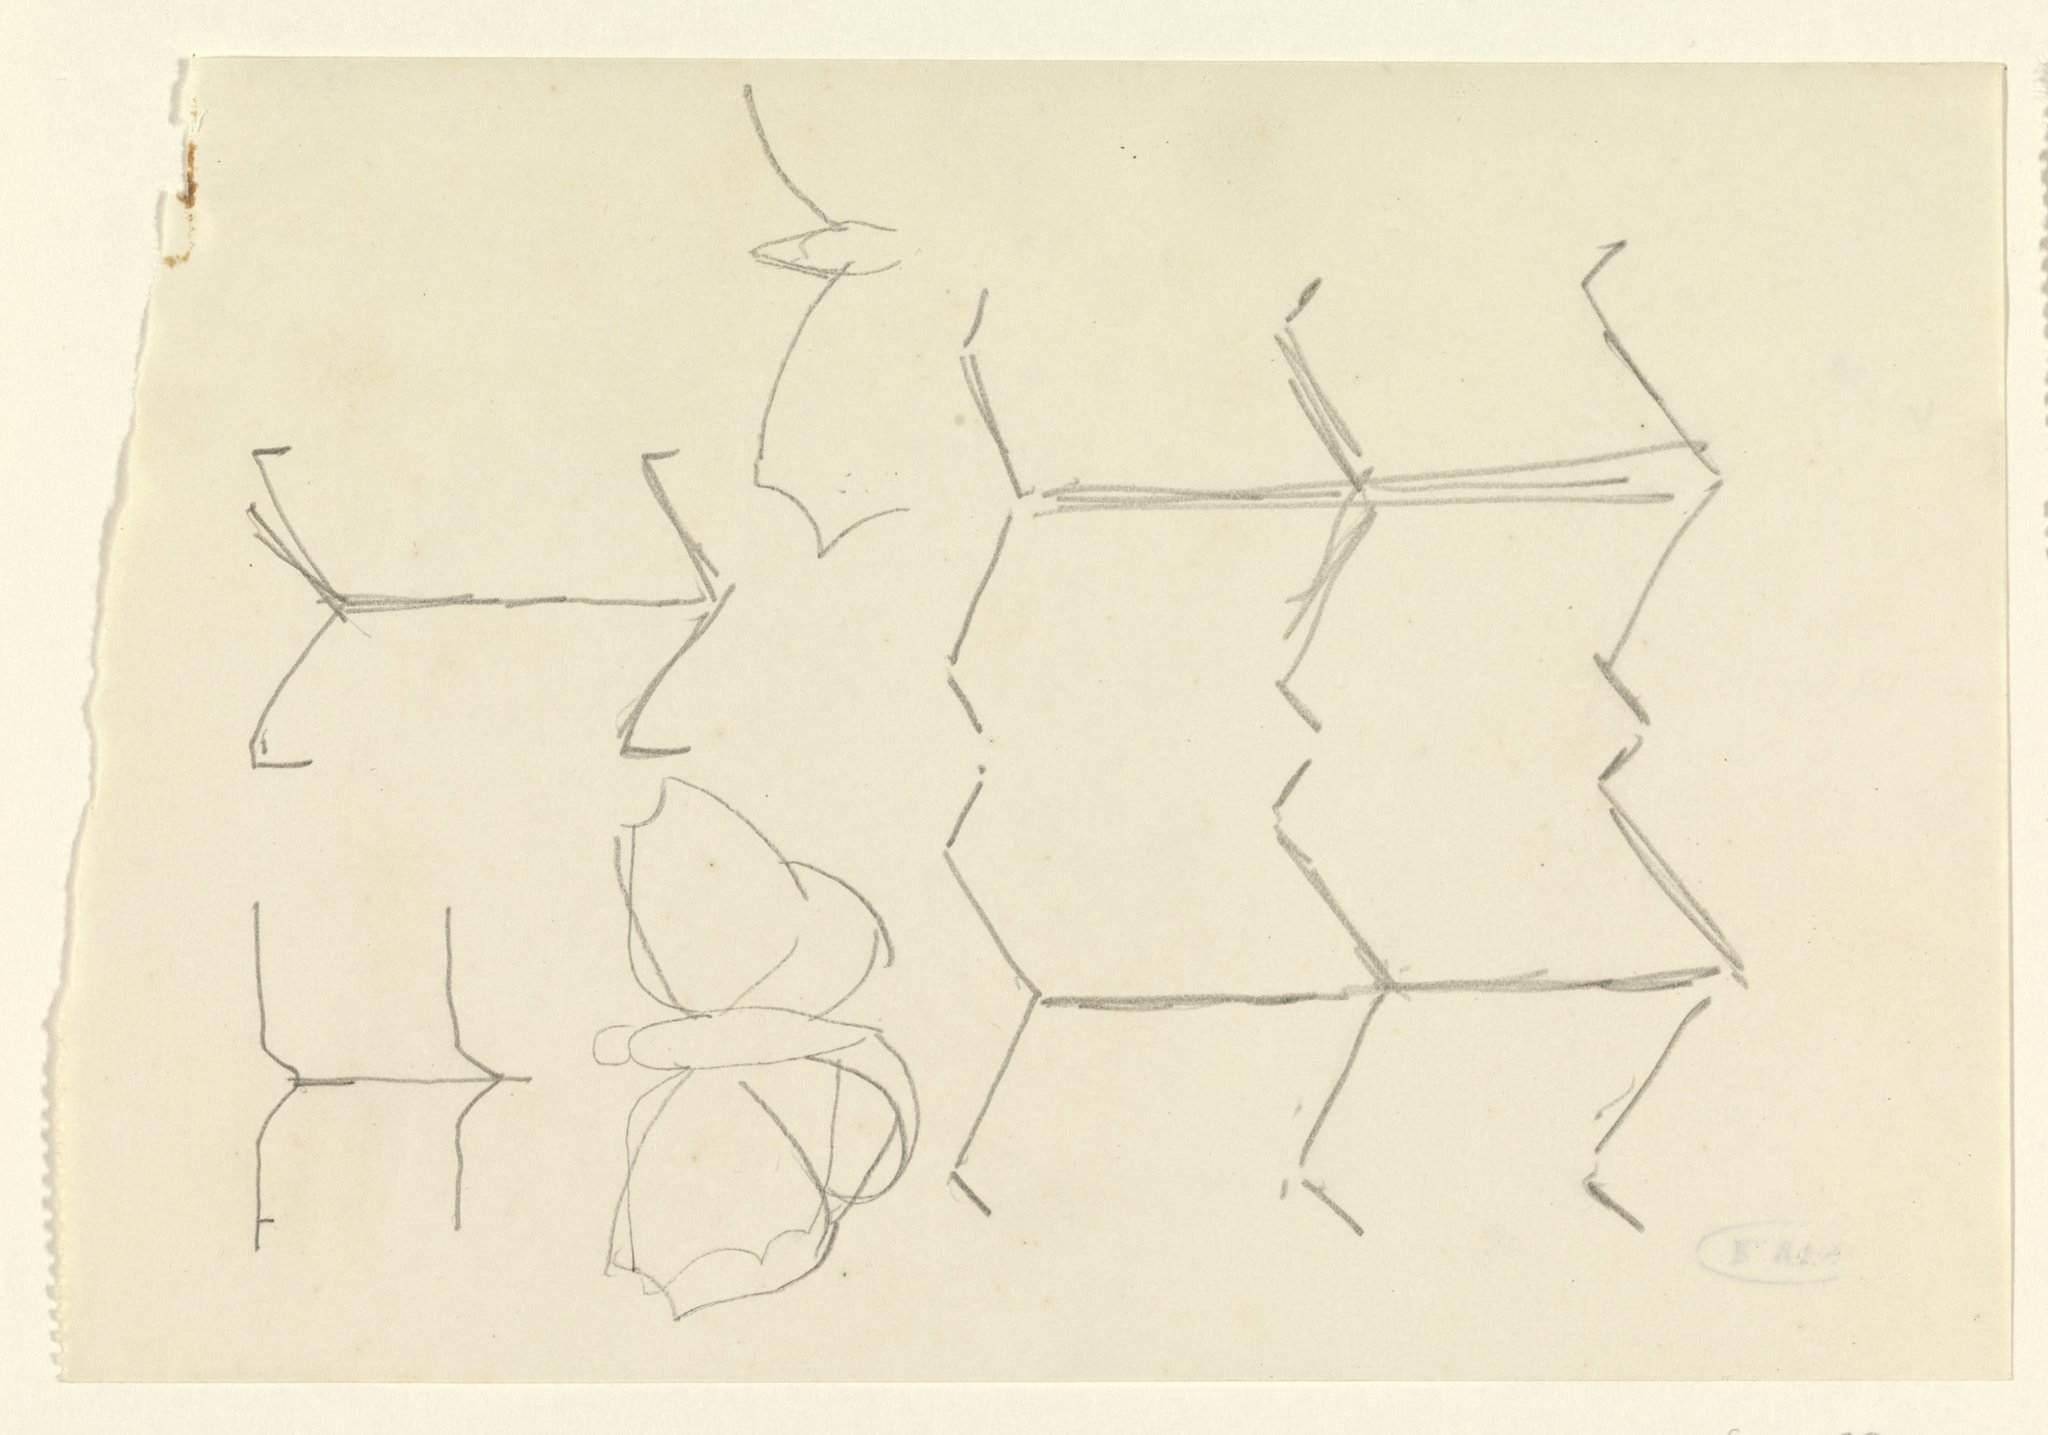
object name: drawing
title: Ornament en twee vlinders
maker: leo gestel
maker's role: draughtsman, print maker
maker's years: 1881-1941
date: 1939-1941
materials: paper, pencil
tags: insects: butterfly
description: Ontwerp voor een watermerk voor een bankbiljet.